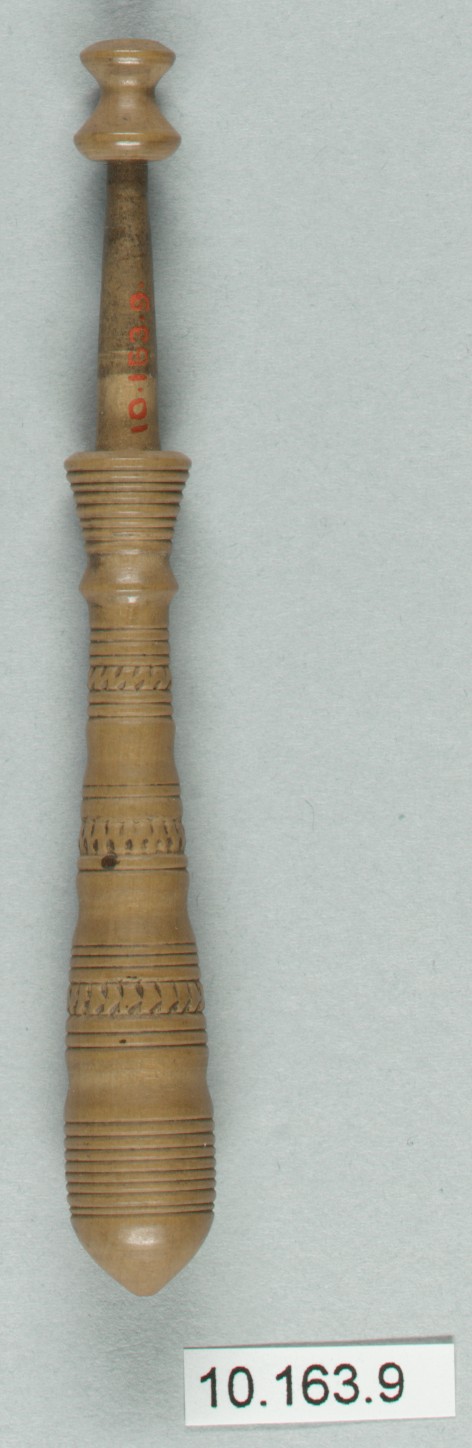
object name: bobbin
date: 1801-1900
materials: wood